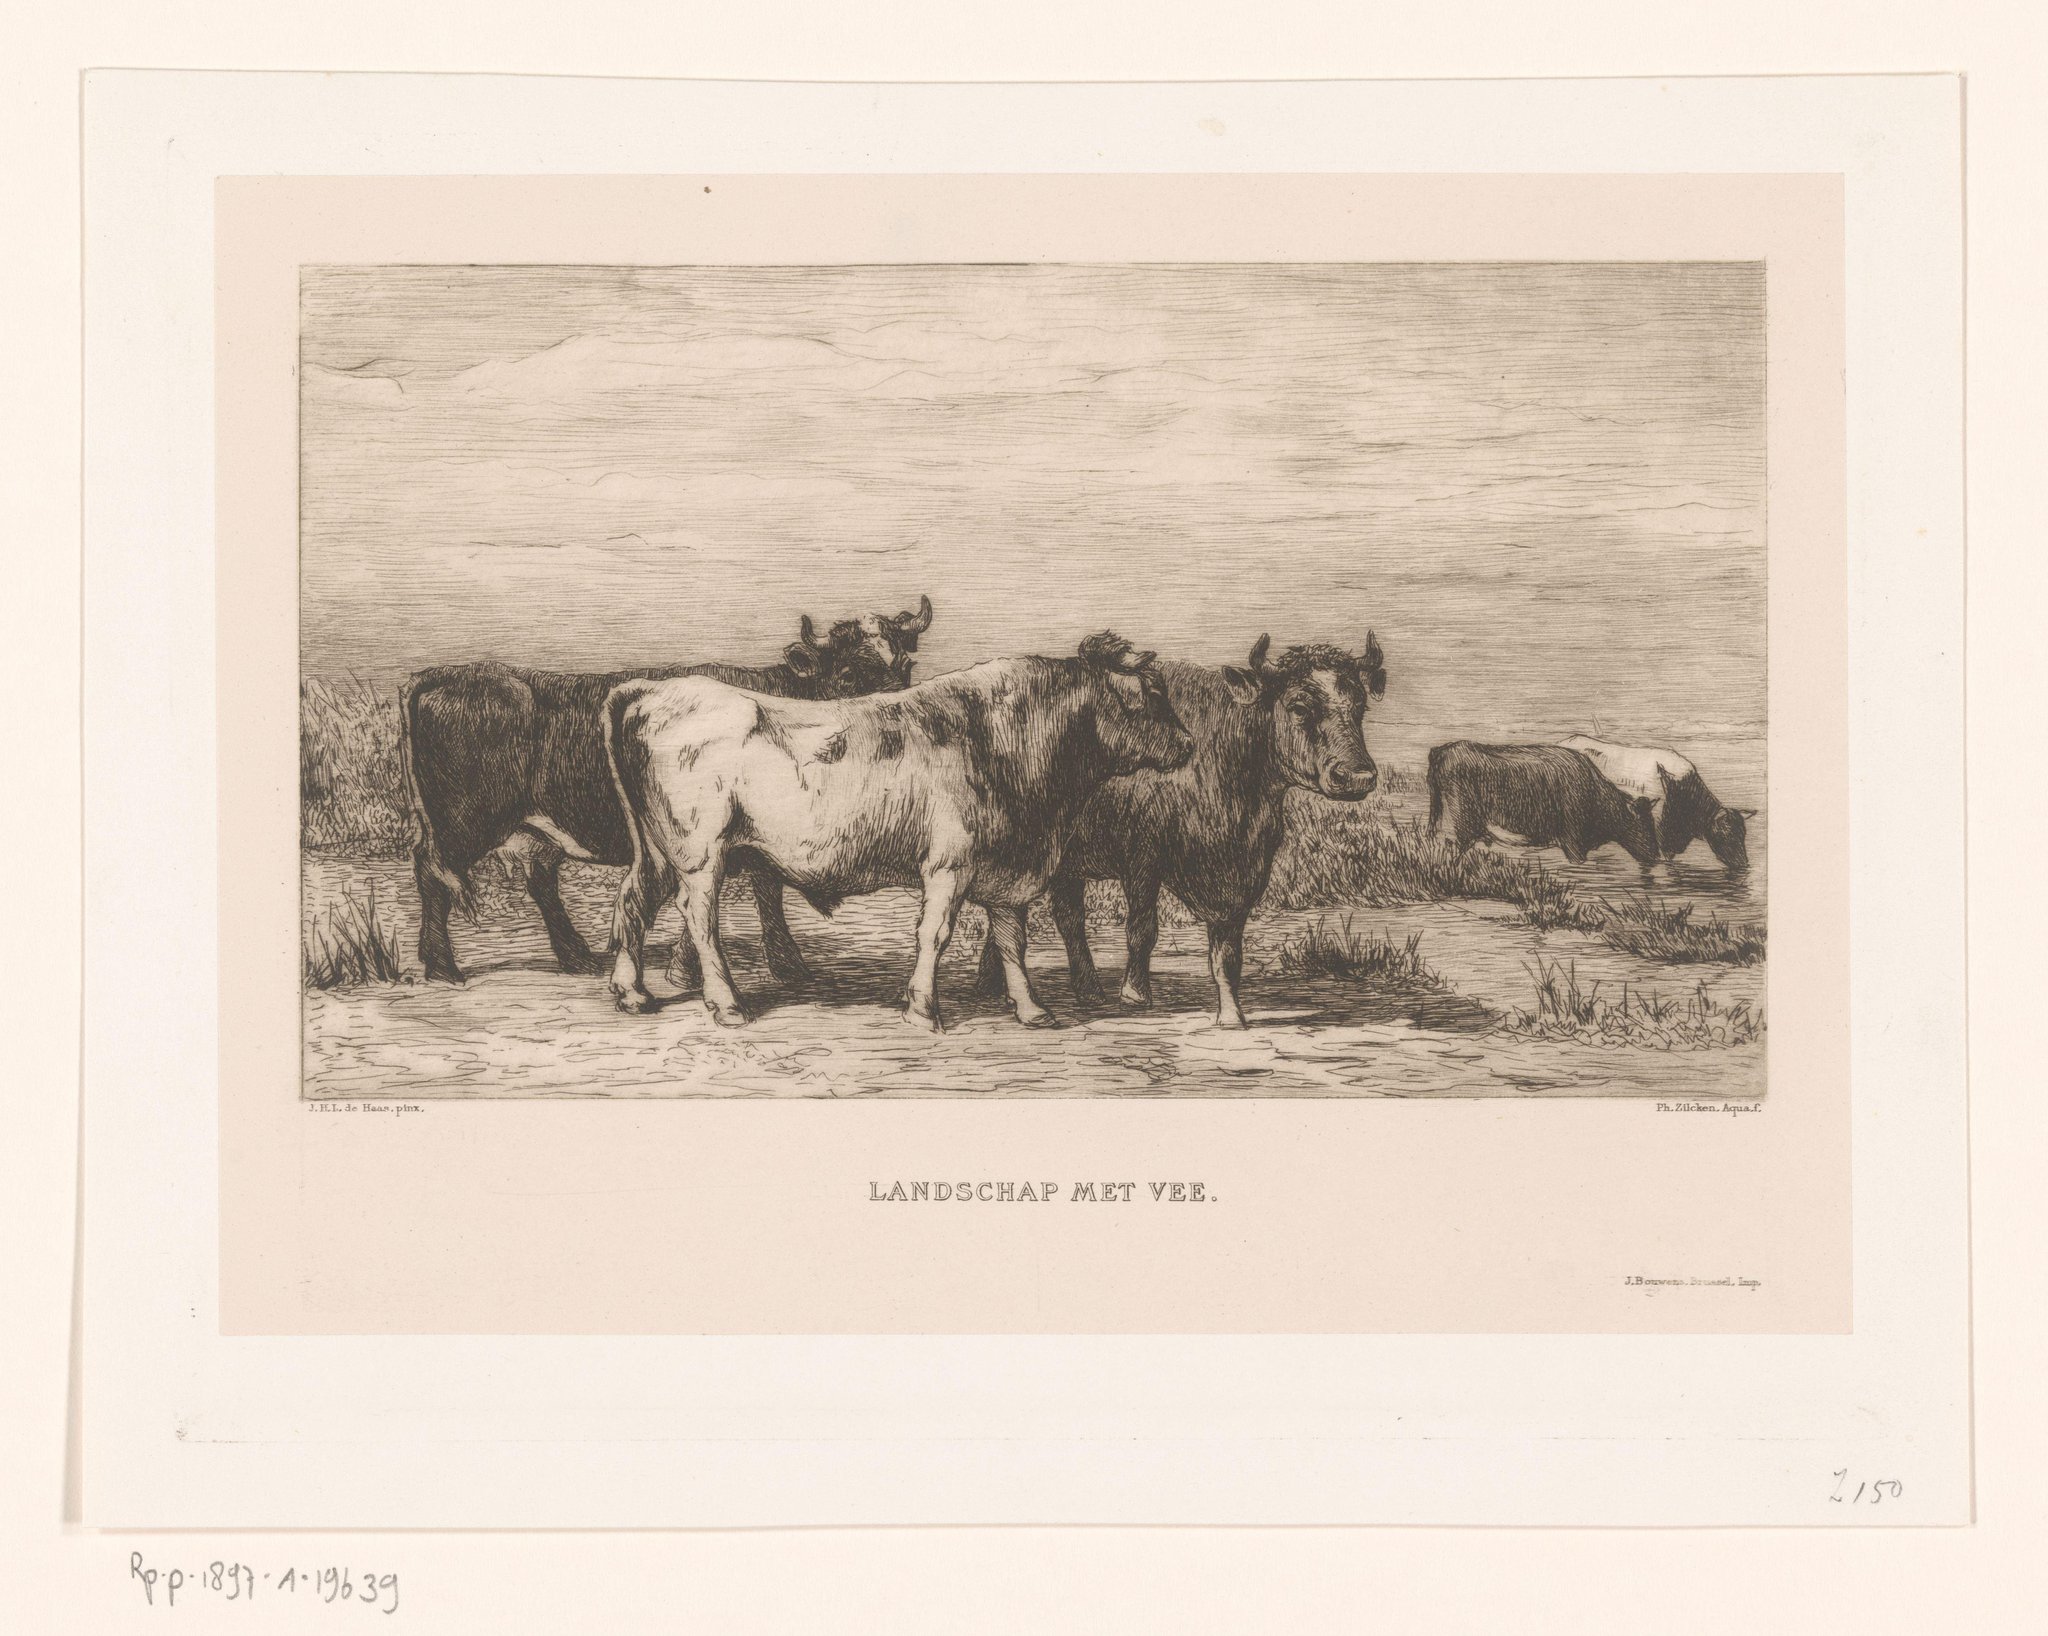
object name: print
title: Landschap met vee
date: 1867-1890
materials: paper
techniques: drypoint, etching, intaglio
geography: brussels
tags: bovine cattle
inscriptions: collector's mark: Lugt 2228